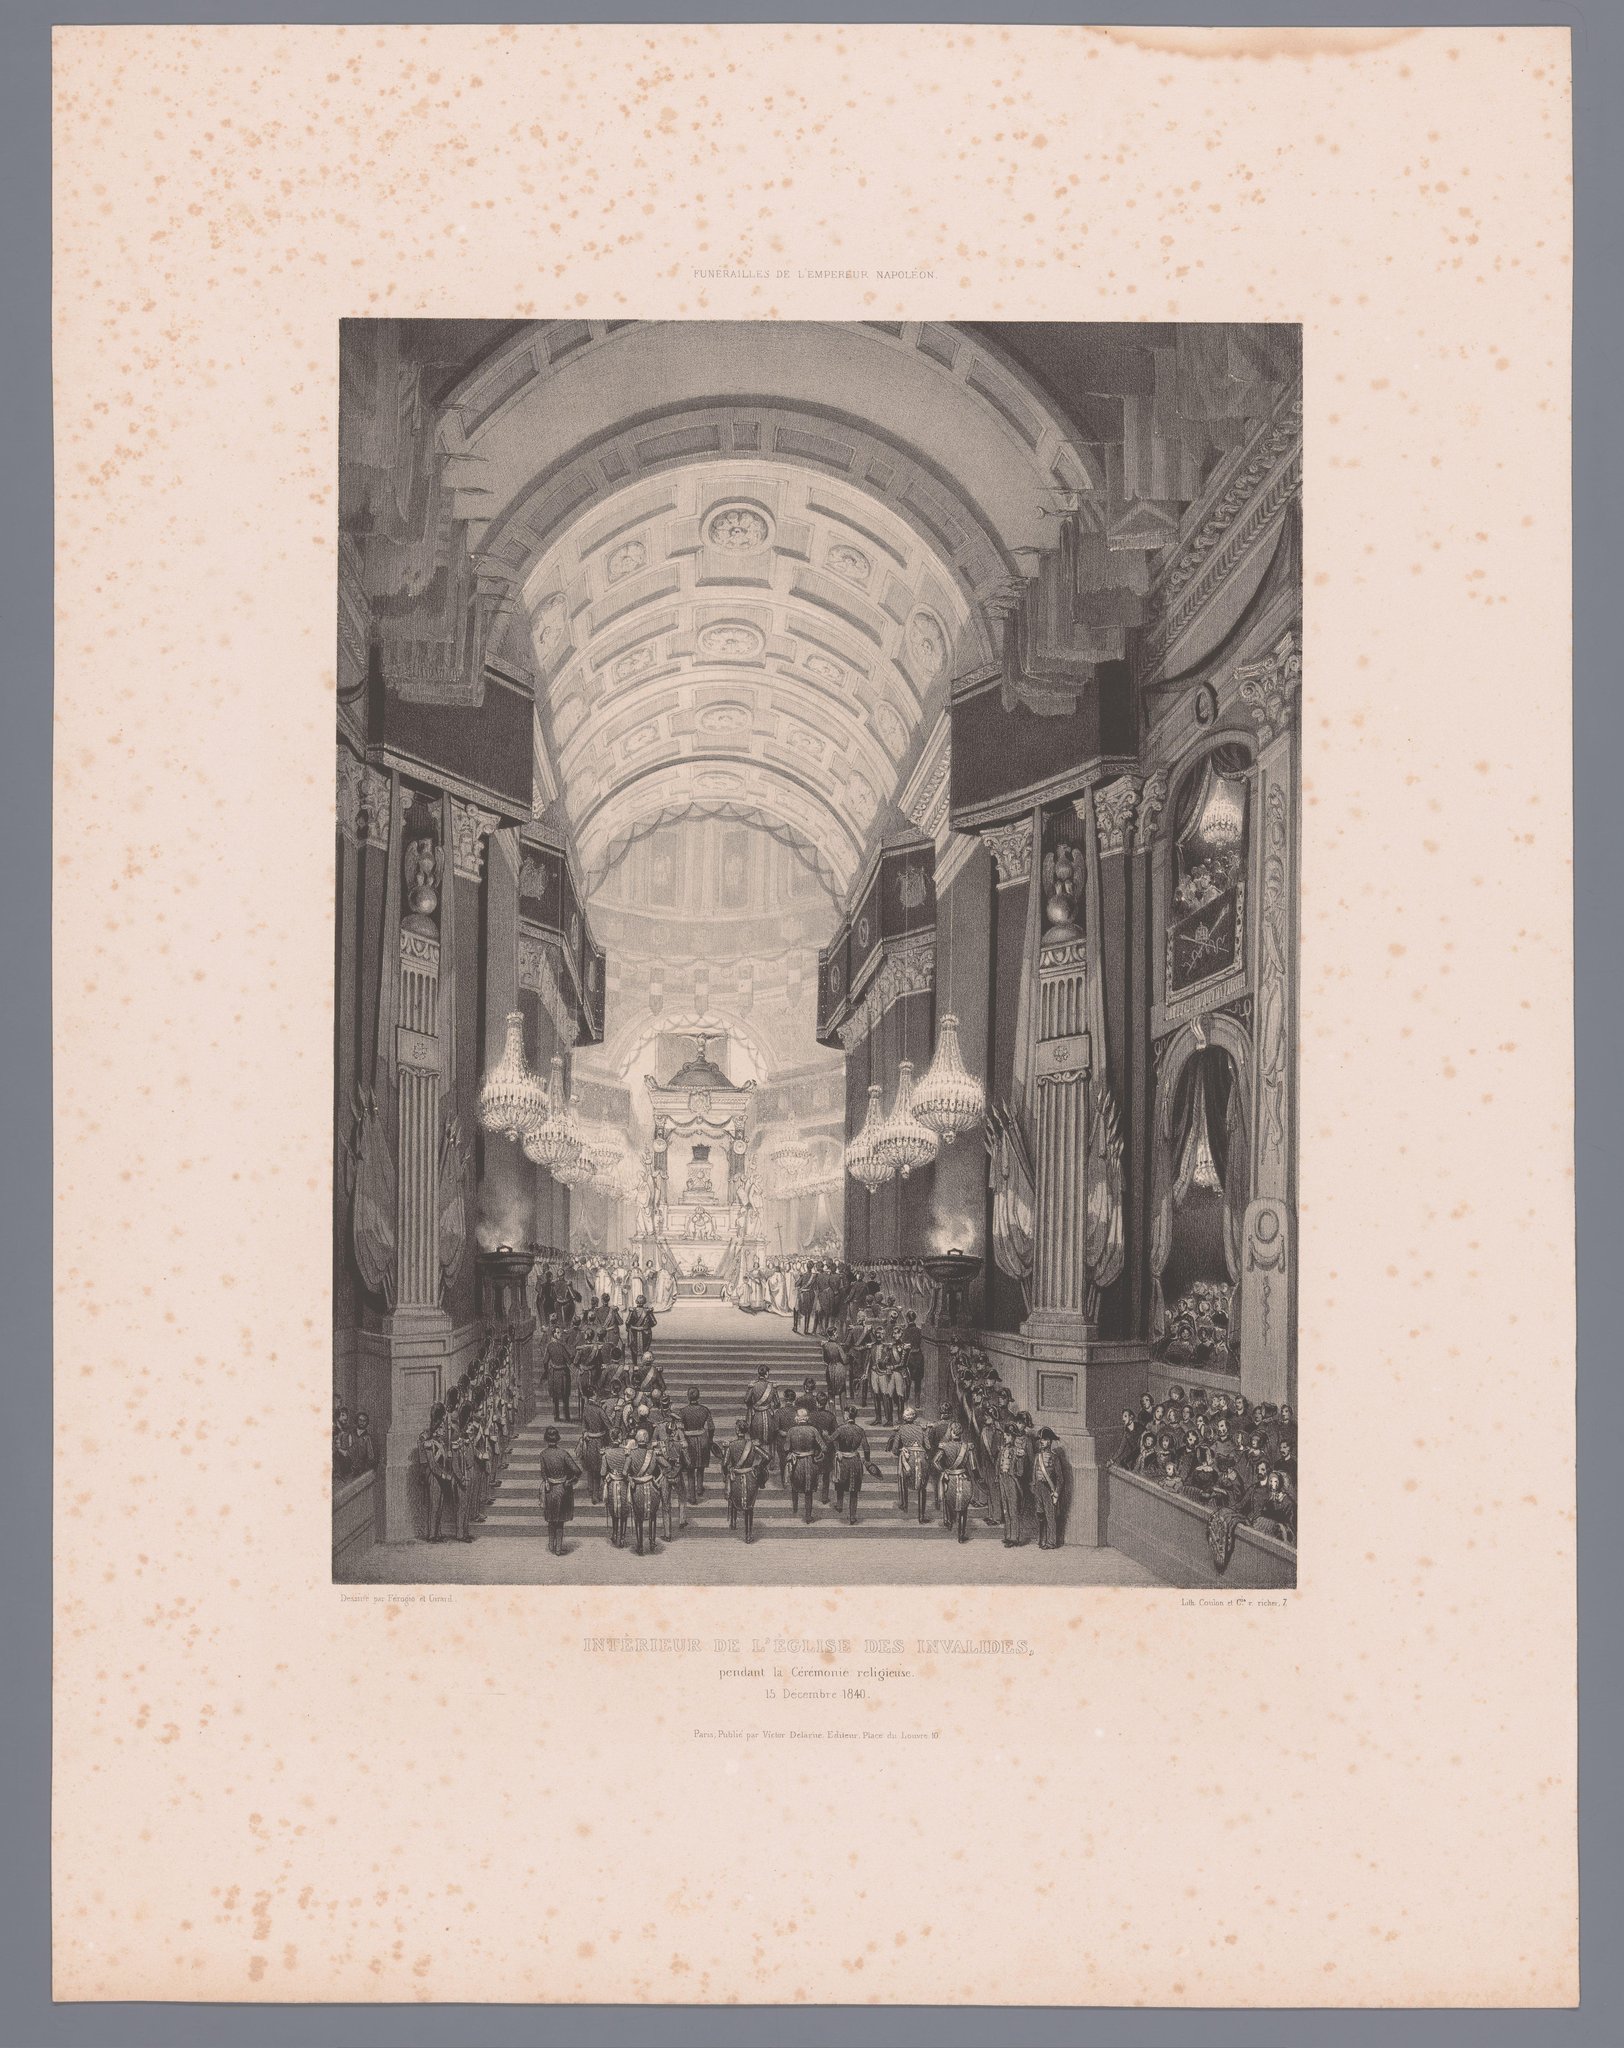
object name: print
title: Intérieur de l'église des Invalides pendant la Cérémonie religieuse (15 Décembre 1840)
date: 1841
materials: paper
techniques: lithograph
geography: paris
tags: office of the dead, interior of church, funerary ceremonial, grave-building, monumental tomb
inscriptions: collector's mark: Lugt 2228a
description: Prent maakt deel uit van een omslag met zeven prenten.